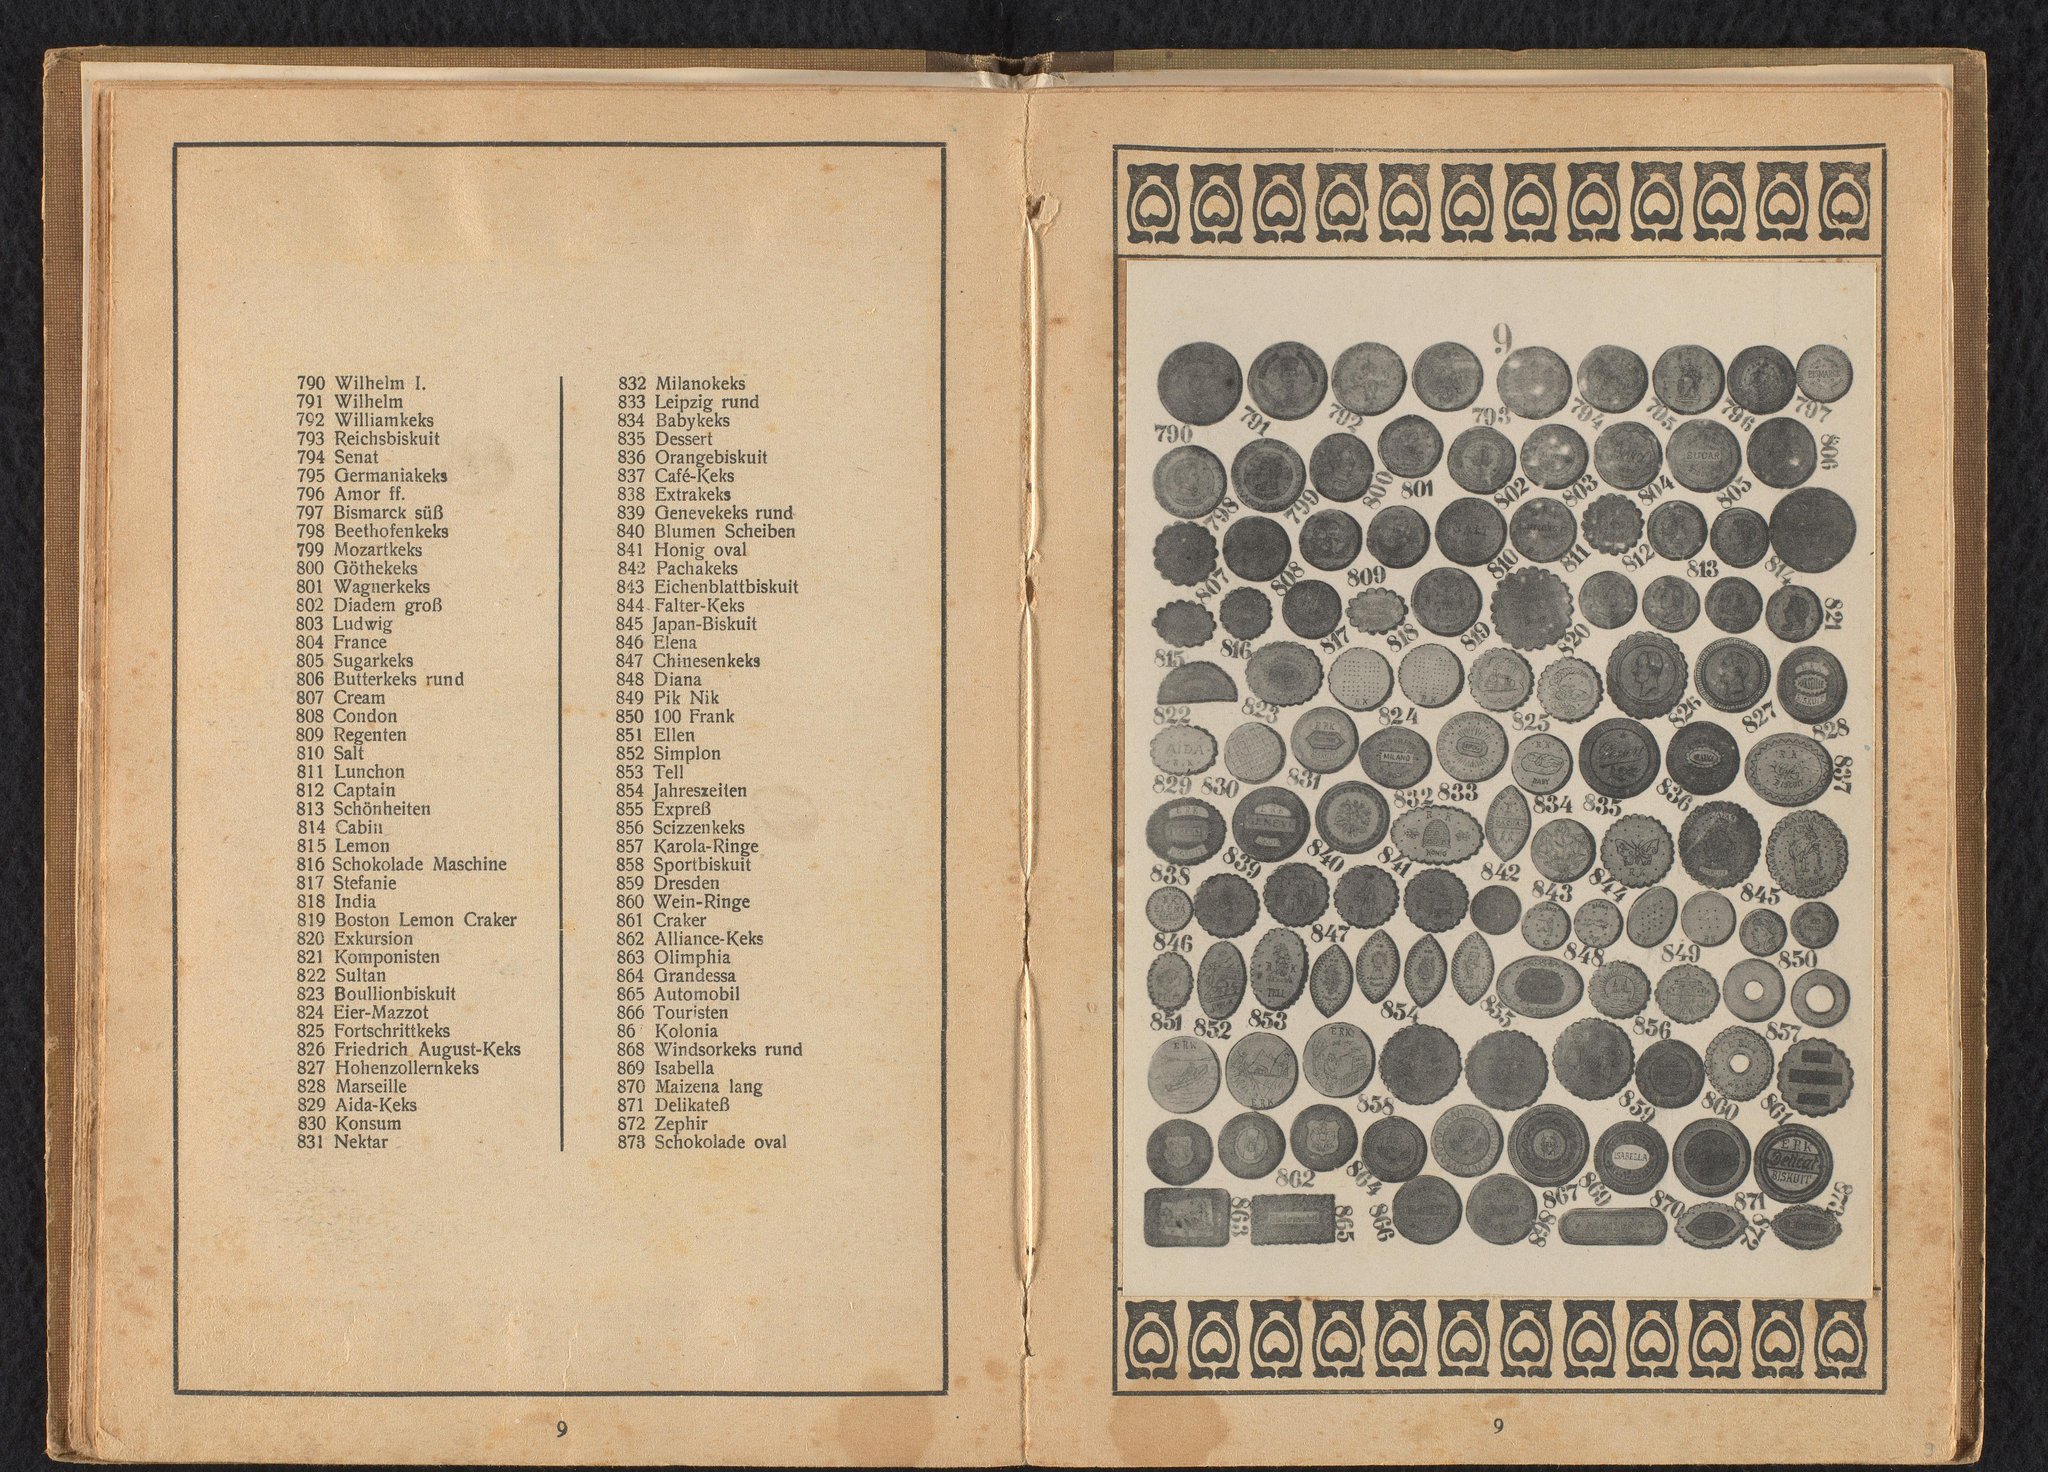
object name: photomechanical print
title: Verschillende Engelse koekjes en biscuits als voorbeeld bij recepten 790-873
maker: Anonymous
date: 1900-1905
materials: paper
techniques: photograph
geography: bad langensalza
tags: pastry cook, moulds for biscuits, biscuits